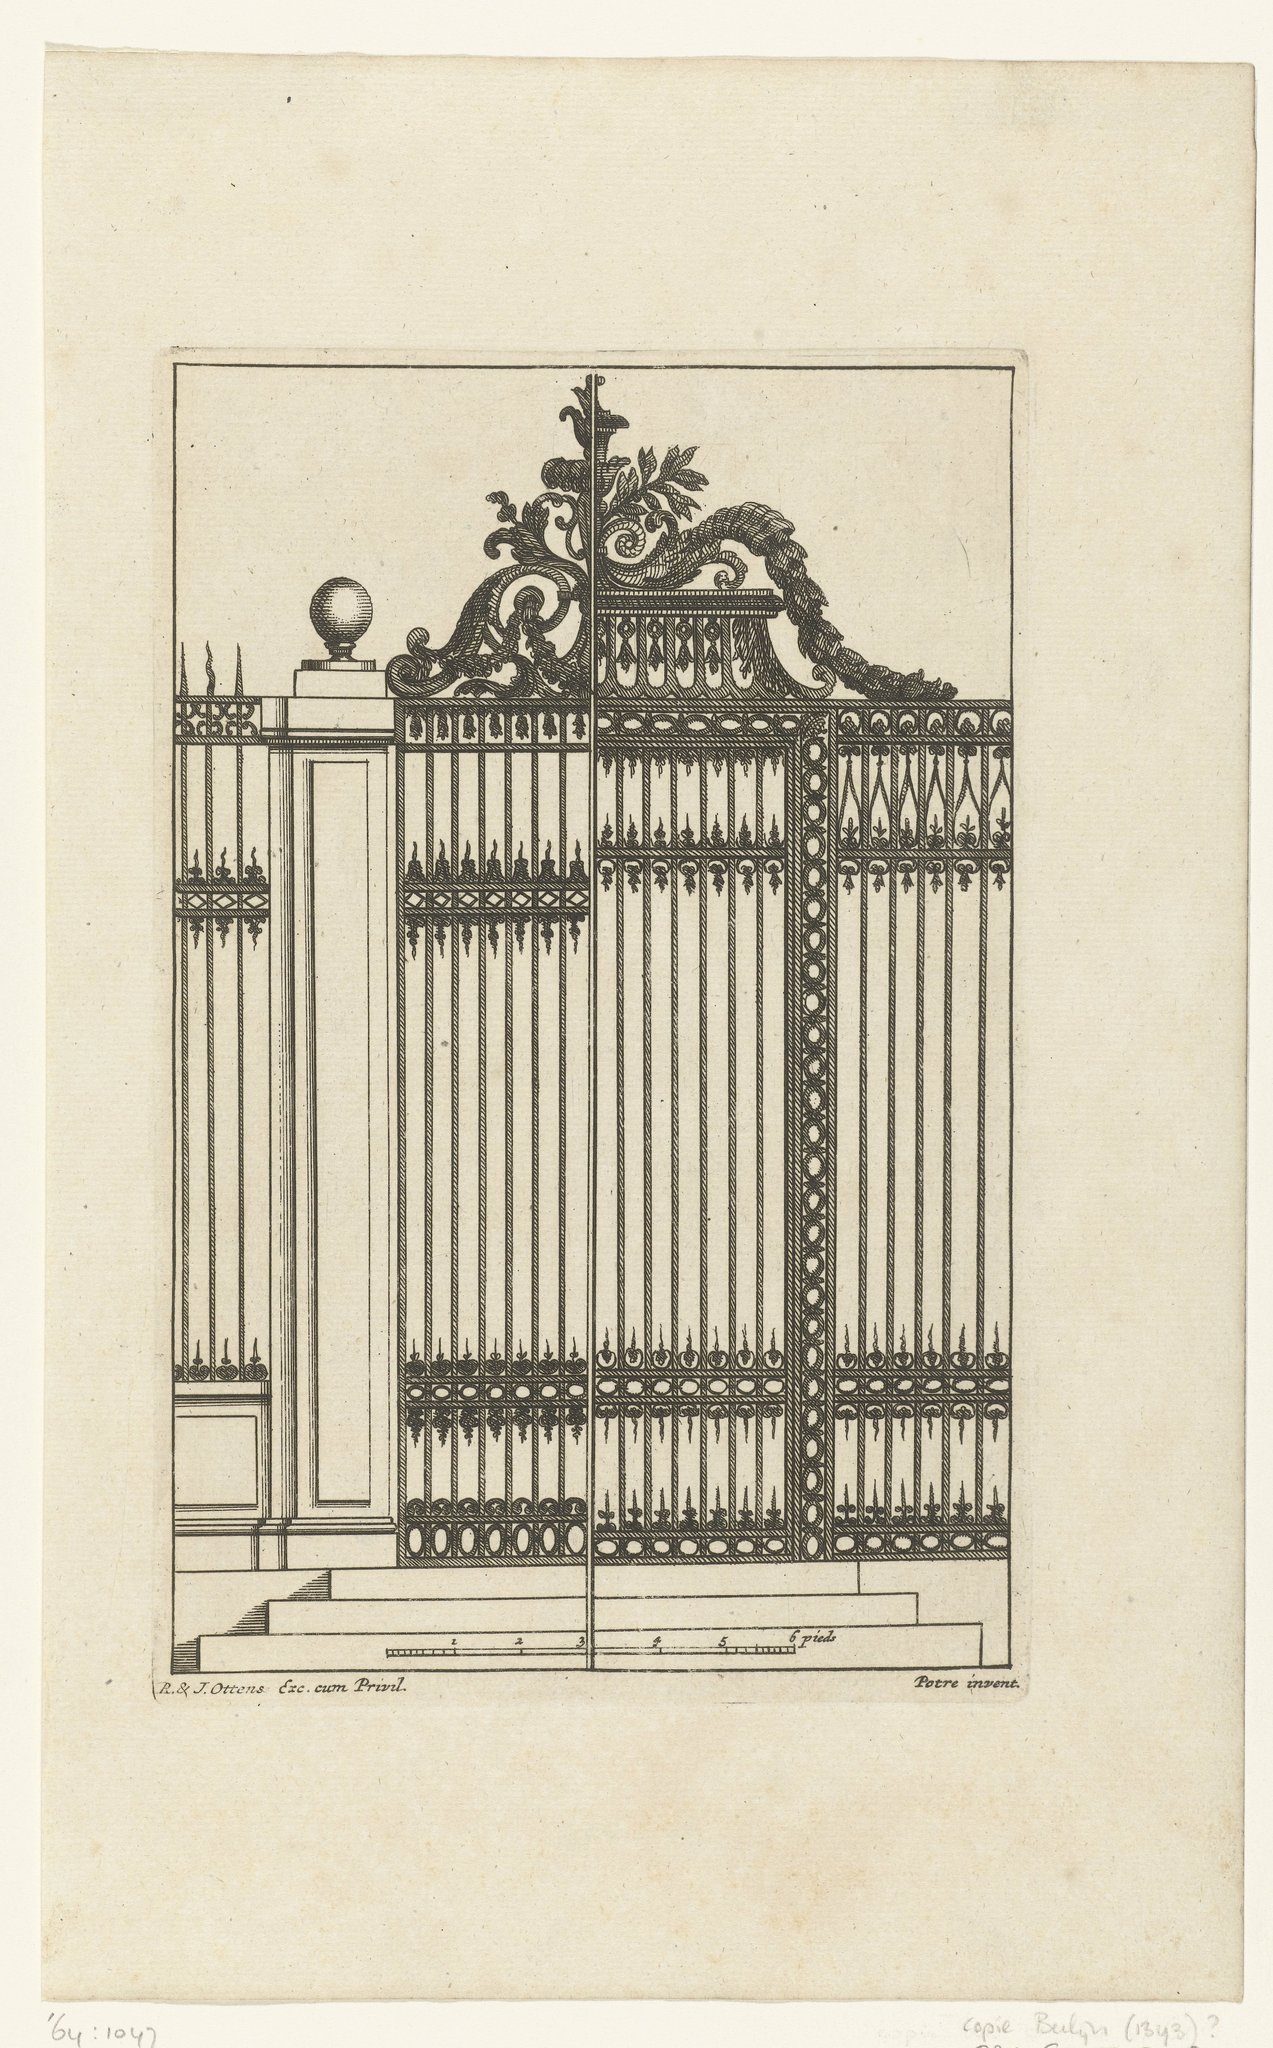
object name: titelblad, titelpagina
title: Smeedwerk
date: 1726-1750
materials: paper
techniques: etching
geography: france